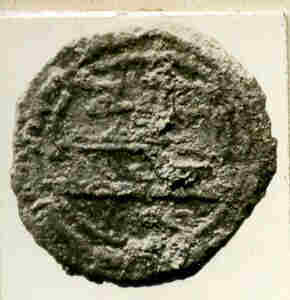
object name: coin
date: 951-1022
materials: copper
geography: iran